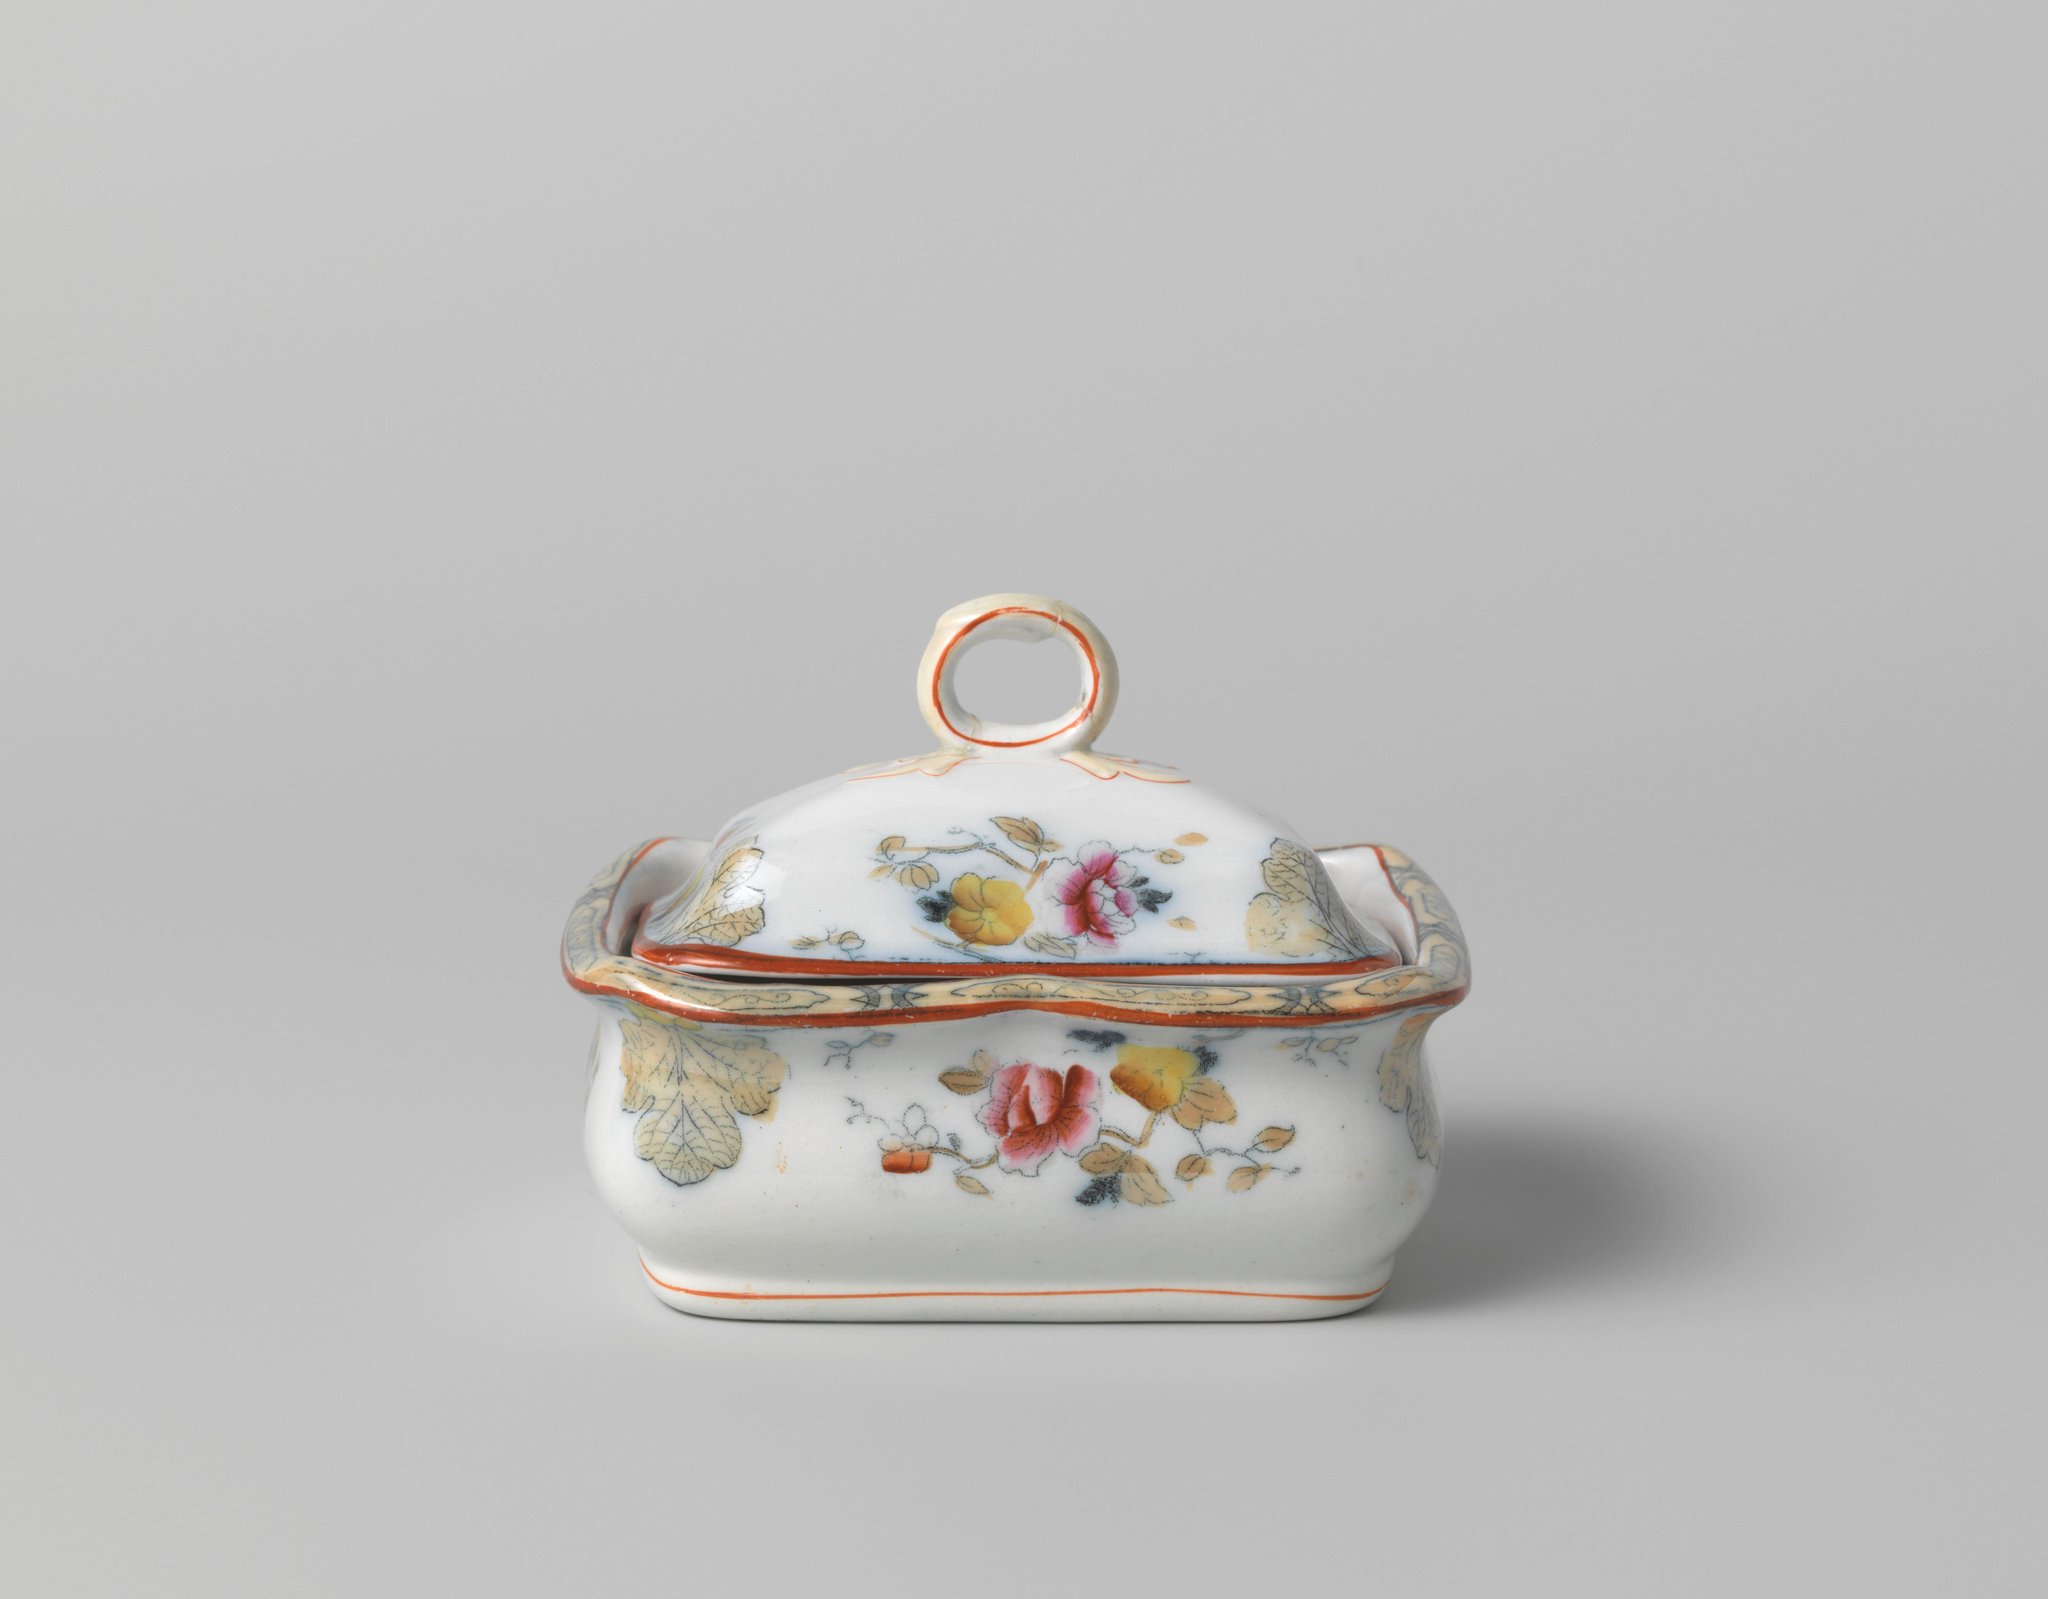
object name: soap box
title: Deksel met veelkleurige bloemen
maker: petrus regout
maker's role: plateelbakker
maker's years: 1801-1879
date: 1882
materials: earthenware, glaze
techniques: vitrification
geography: maastricht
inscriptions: check stamp: ‘F .. (?)’, mark: ‘sfinx // P. REGOUT & Co // MAASTRICHT // VESTA’, check stamp: ‘F AC’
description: Het deksel wordt bekroond door een knop in de vorm van omgekruld bladwerk.